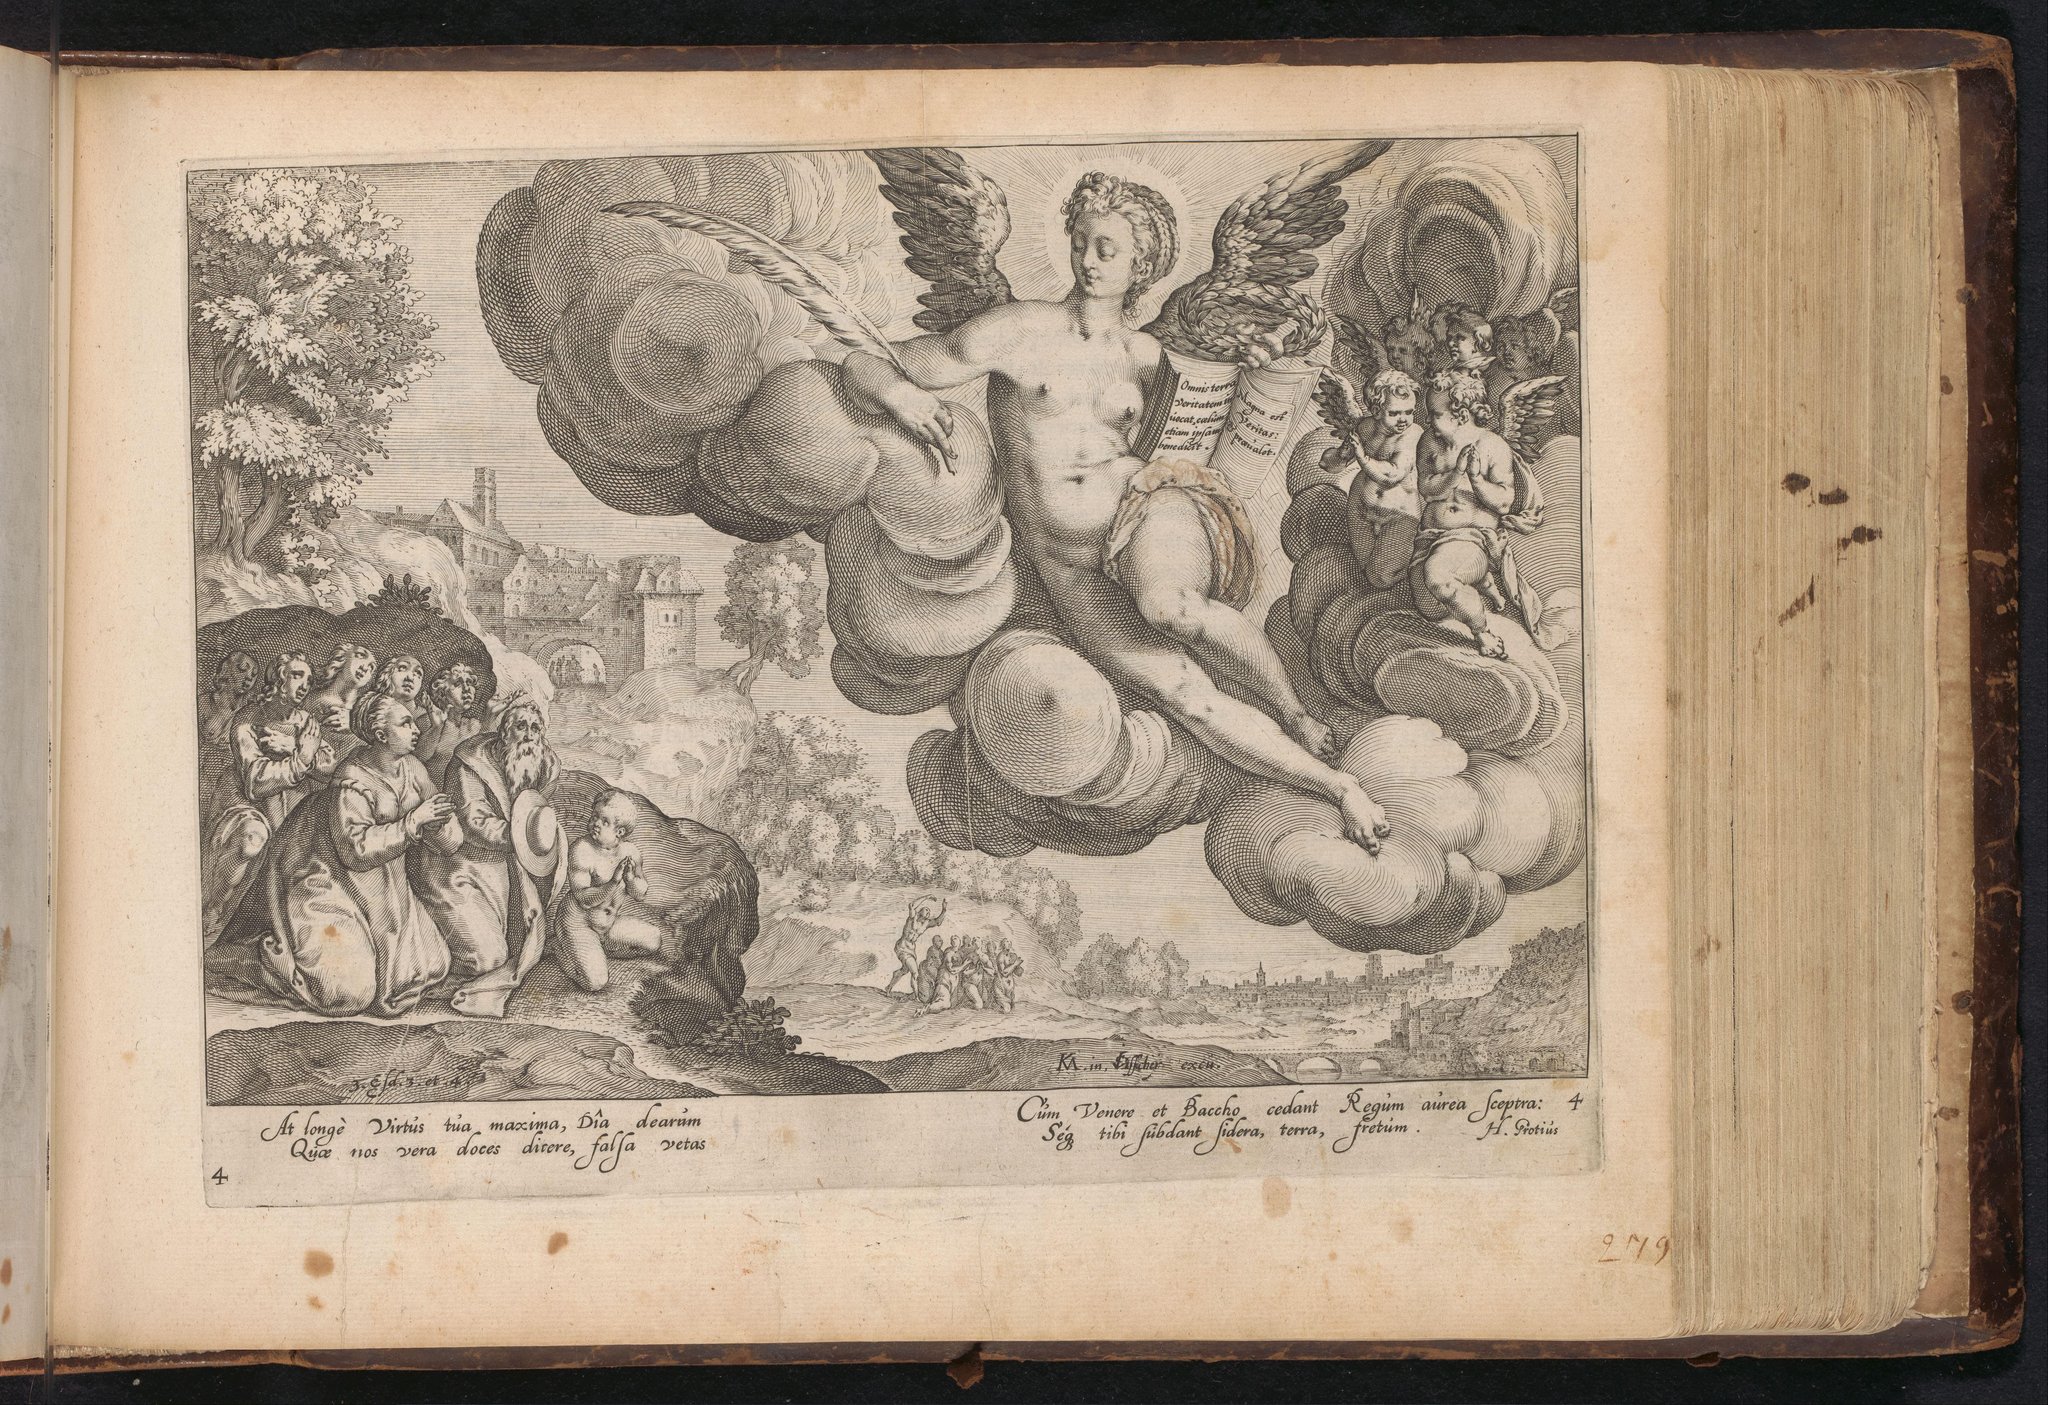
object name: print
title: Den Grooten Figuer-Bibel (...)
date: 1595-1596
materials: paper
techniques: engraving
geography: amsterdam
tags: the books of ezra, nehemiah, and esdras, zerubbabel says (writes) that truth is the strongest of all things ~ contest of the three guardsmen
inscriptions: number: ‘279’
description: De personificatie van de Waarheid zit op een wolk, naast haar een groepje engelen. Zij houdt een palmtak, een lauwerkrans en een boek vast. In een landschap knielen groepjes mensen eerbiedig voor de verschijning van de Waarheid. Linksonder een verwijzing naar de tekst in 3 Esdras 3-4. Onder de voorstelling verzen in het Latijn. Deze prent maakt deel uit van een album.